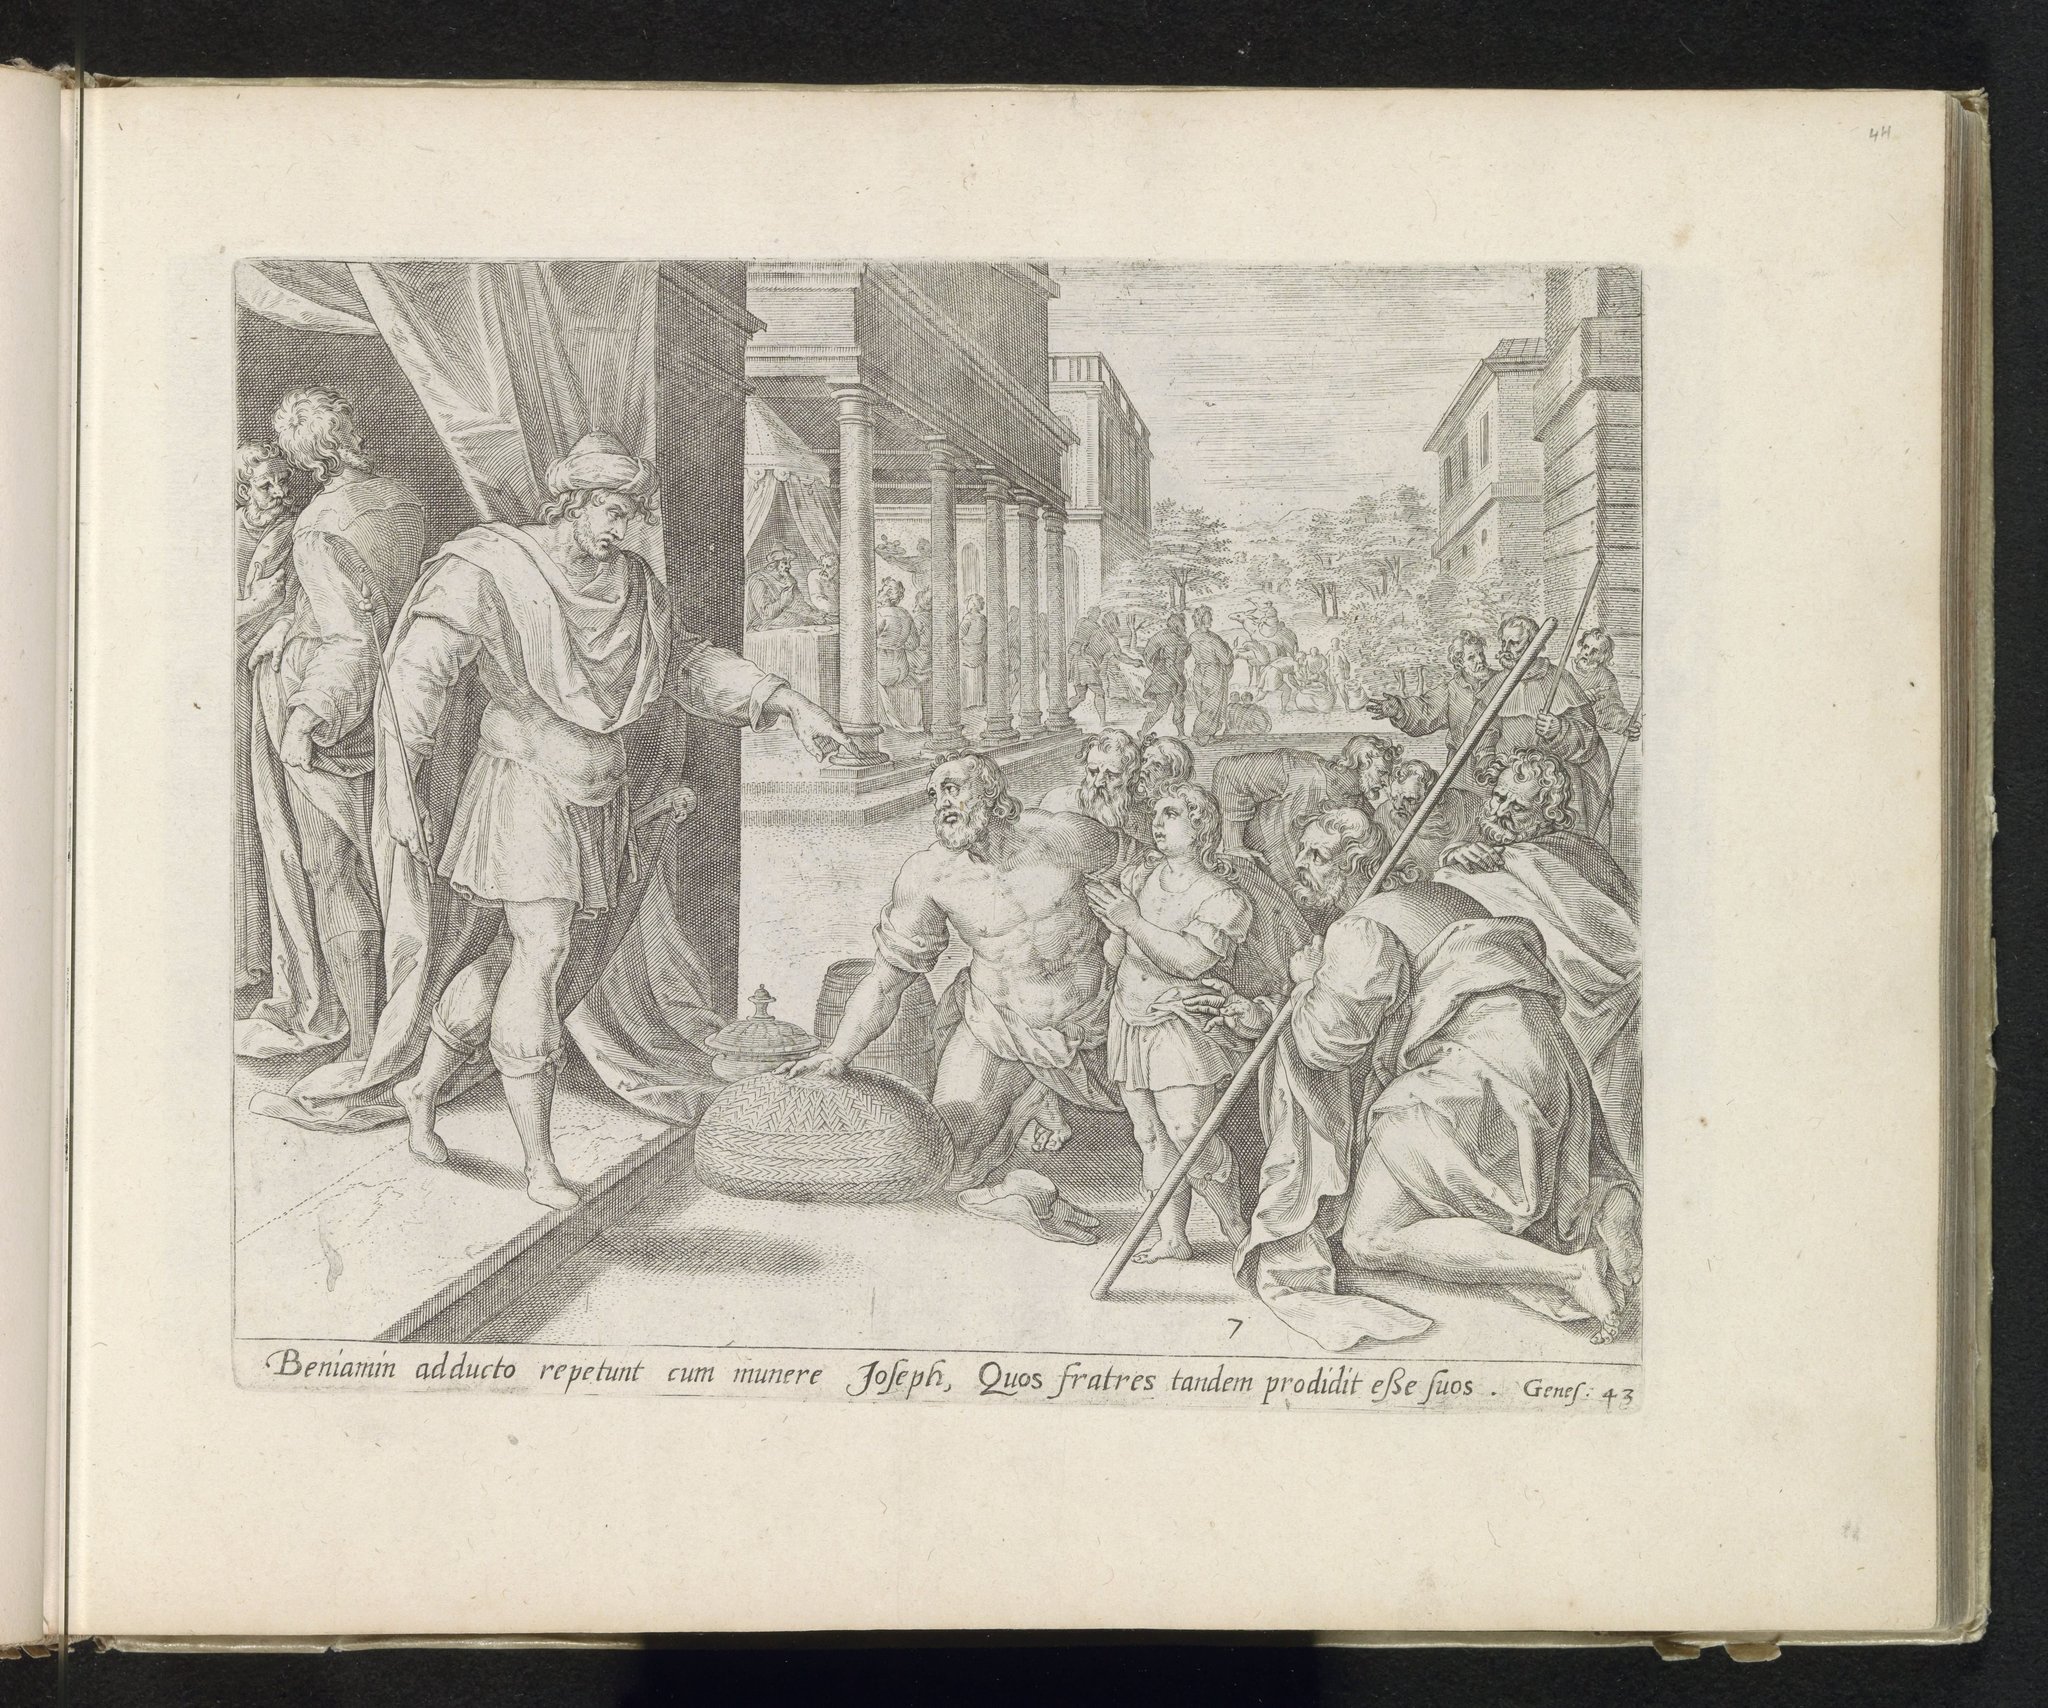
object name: album leaf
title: Geschiedenis van Jozef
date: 1585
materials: paper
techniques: engraving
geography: antwerp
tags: joseph receives his brothers and benjamin, the missing cup ~ story of joseph (genesis 44-45), the feast at joseph's house: the amazement of his brothers at being seated according to their age; benjamin is honoured with extra food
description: Jozefs broers zijn met hun kleine broer Benjamin teruggekeerd naar Egypte en knielen voor Jozef. Hij nodigt hen uit voor een maaltijd. Linksachter zitten de broers tegenover Jozef aan de maaltijd. Geheel op de achtergrond is het vervolg van het verhaal te zien: in de zak graan van Benjamin wordt de zilveren beker van Jozef gevonden. Onder de voorstelling een verwijzing in het Latijn naar de Bijbeltekst in Gen. 43. Deze prent maakt deel uit van een album.